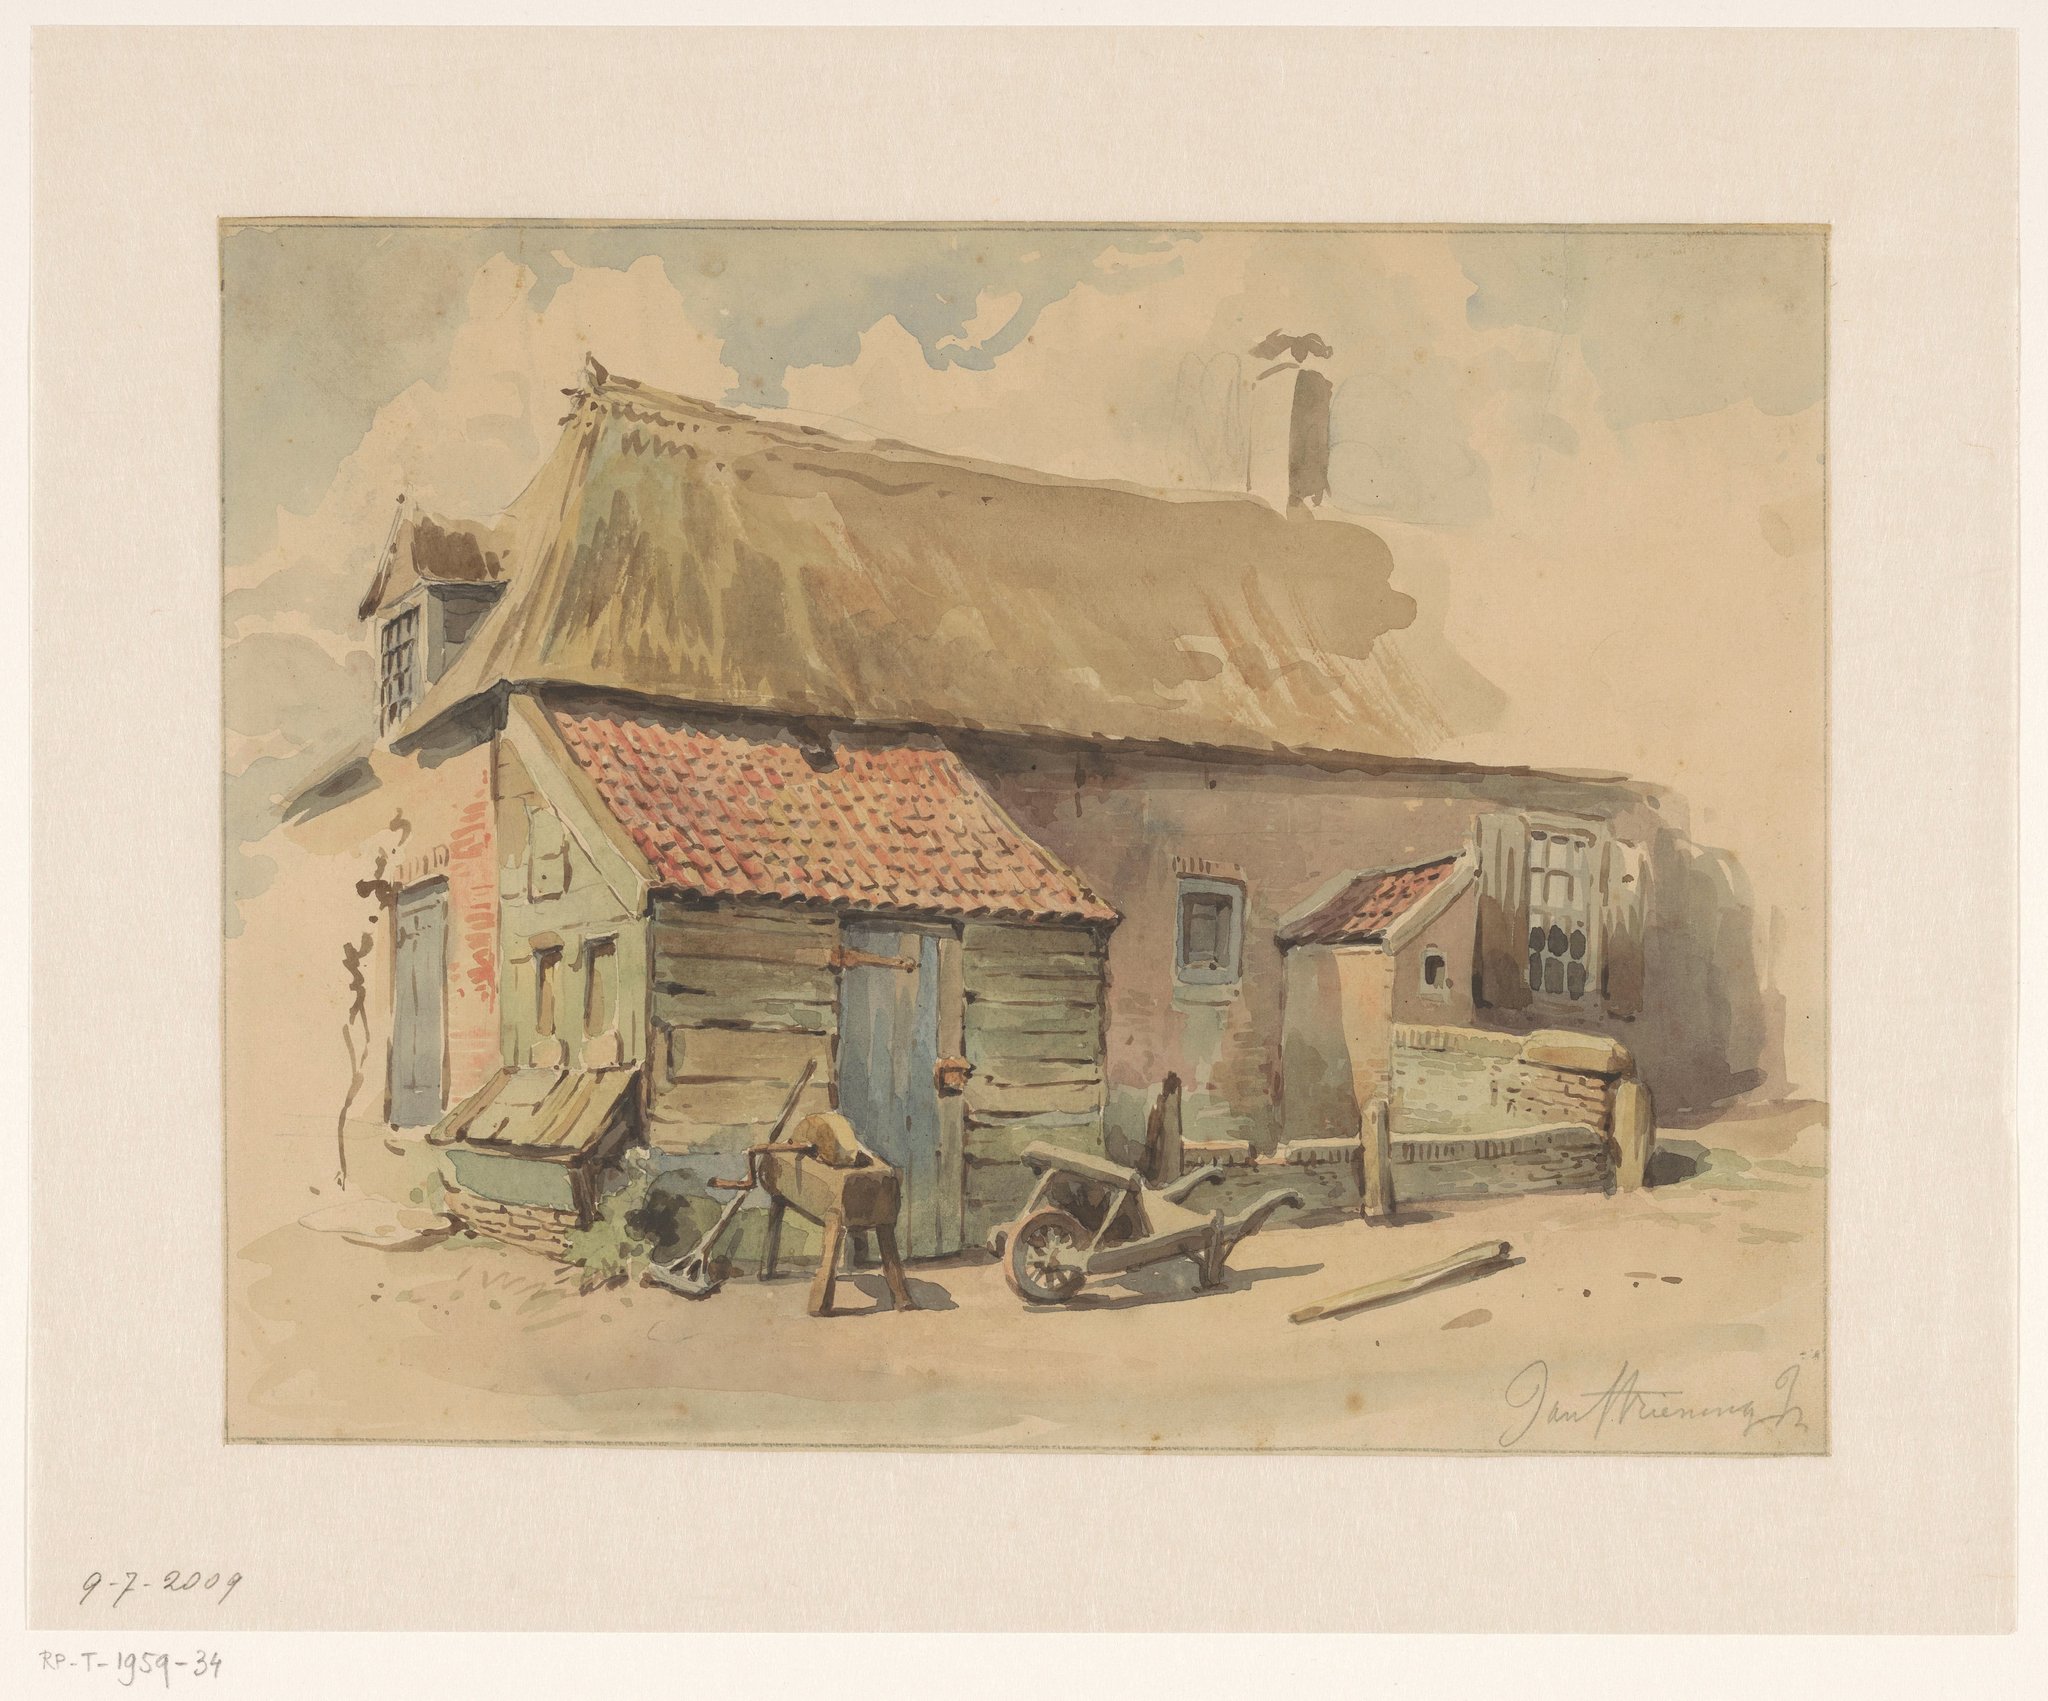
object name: drawing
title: Boerenhuis met houten aanbouw, ervoor een kruiwagen en een slijpsteen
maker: jan striening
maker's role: draughtsman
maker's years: 1827-1903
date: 1837-1903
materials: paper, pencil, watercolor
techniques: brush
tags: farm (building)